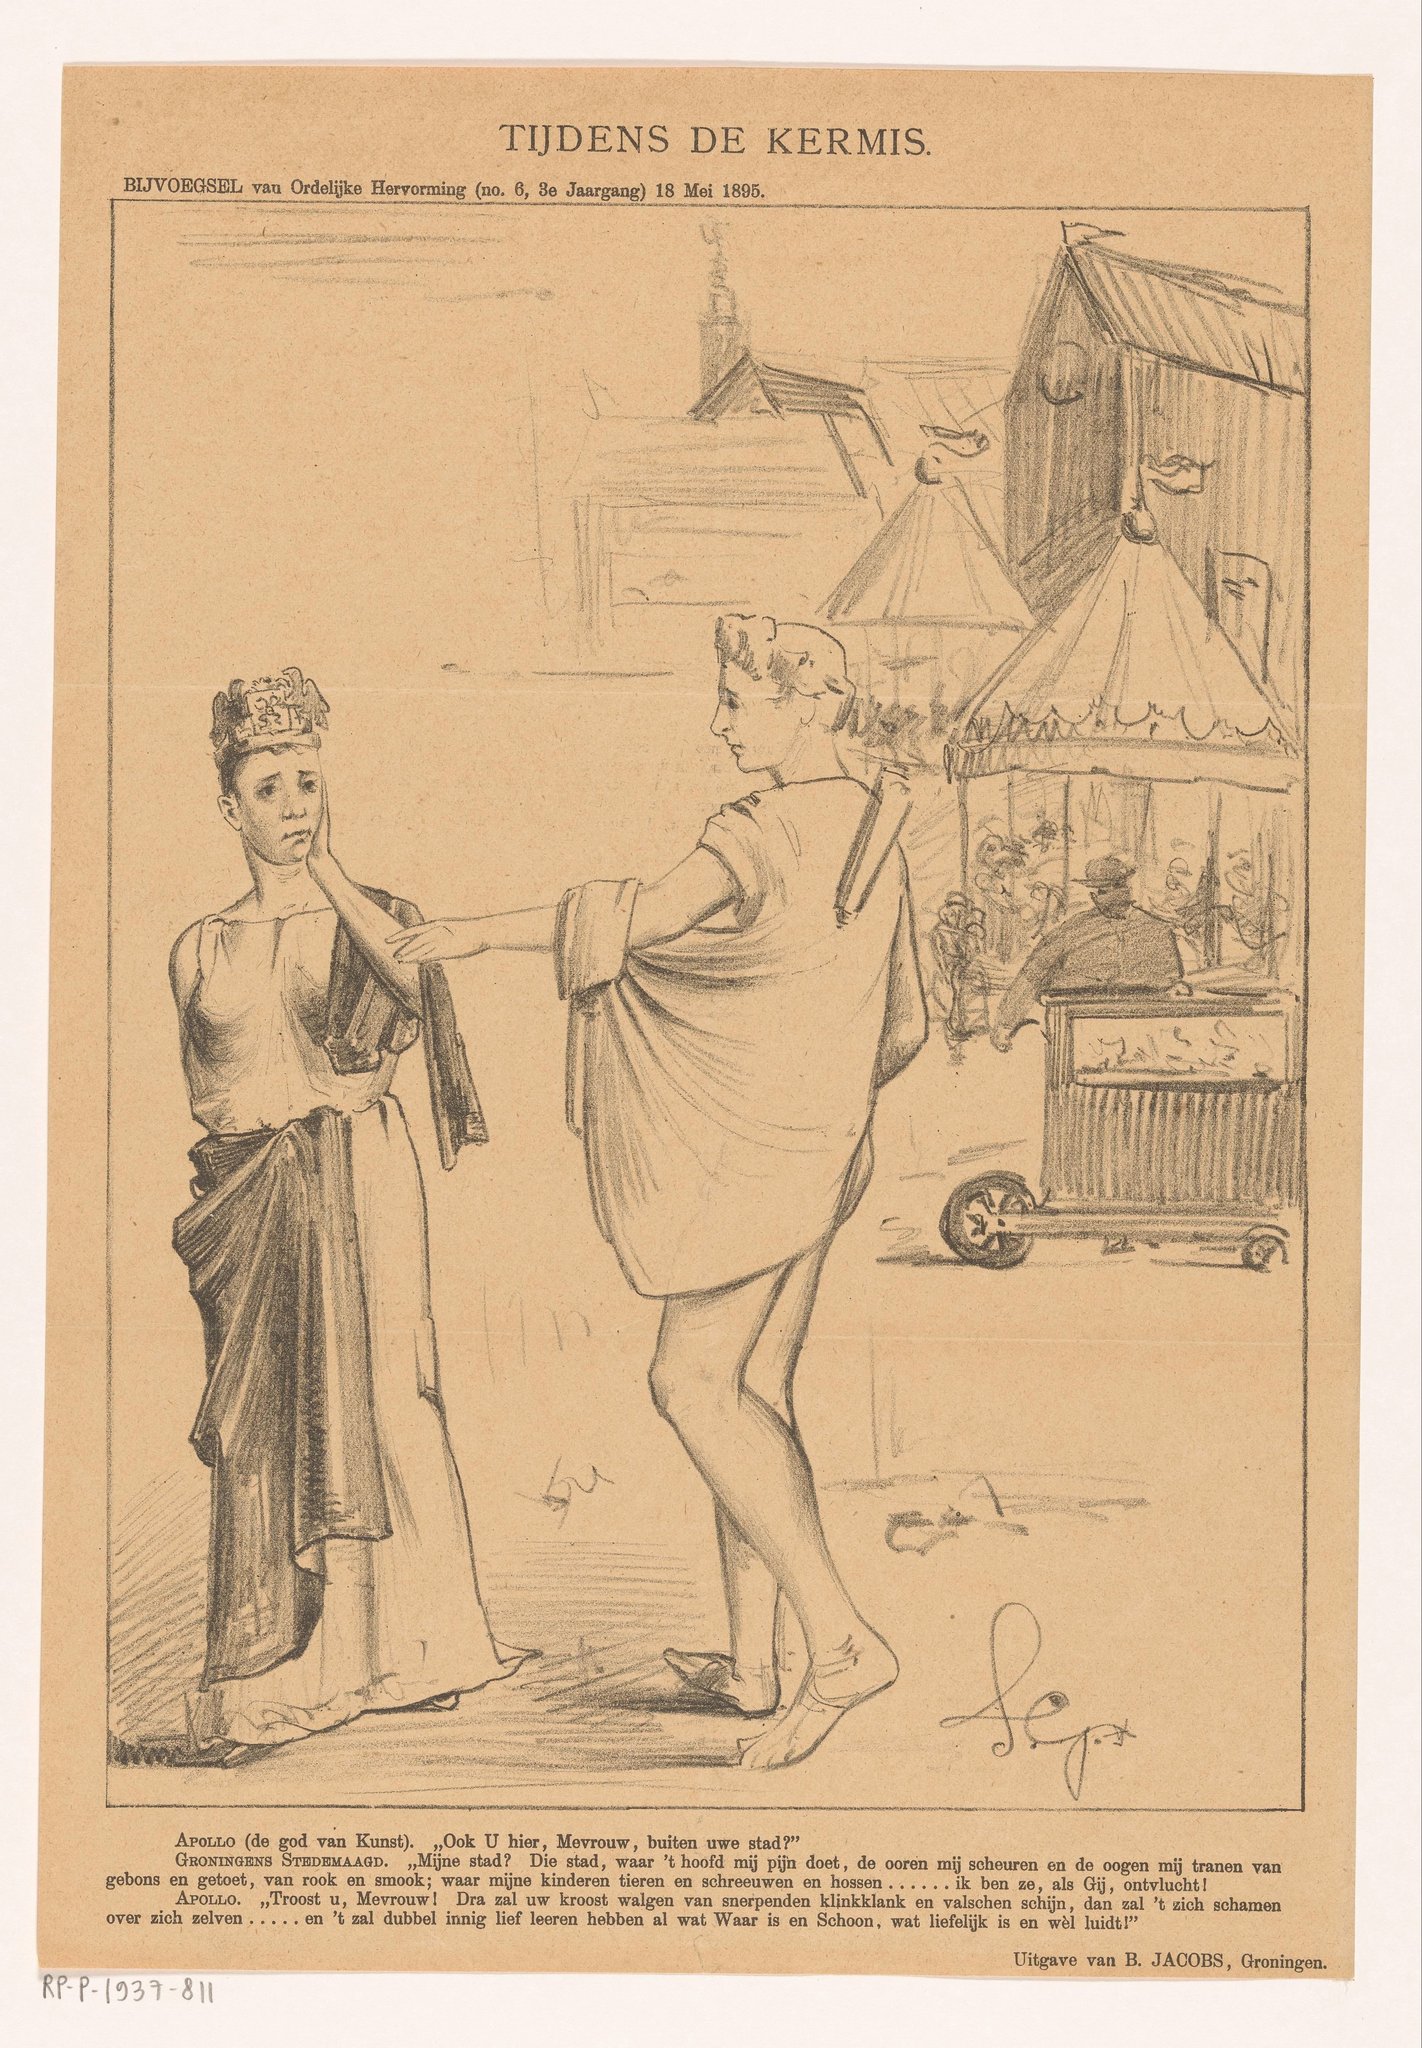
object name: print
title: Tijdens de kermis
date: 1895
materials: paper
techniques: lithograph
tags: personification of a city, town-patron(ess), pleasure fair and circus, specific aspects, allegorical aspects of apollo; apollo as patron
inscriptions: collector's mark: Lugt 2760, collector's mark: Lugt 2228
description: Apollo, beschermgod van de poëzie en de muziek, en de Groningse stedenmaagd met elkaar in gesprek buiten de stad Groningen, die zij beiden ontvlucht zijn. Achter hen mensen op de kermis in Groningen.